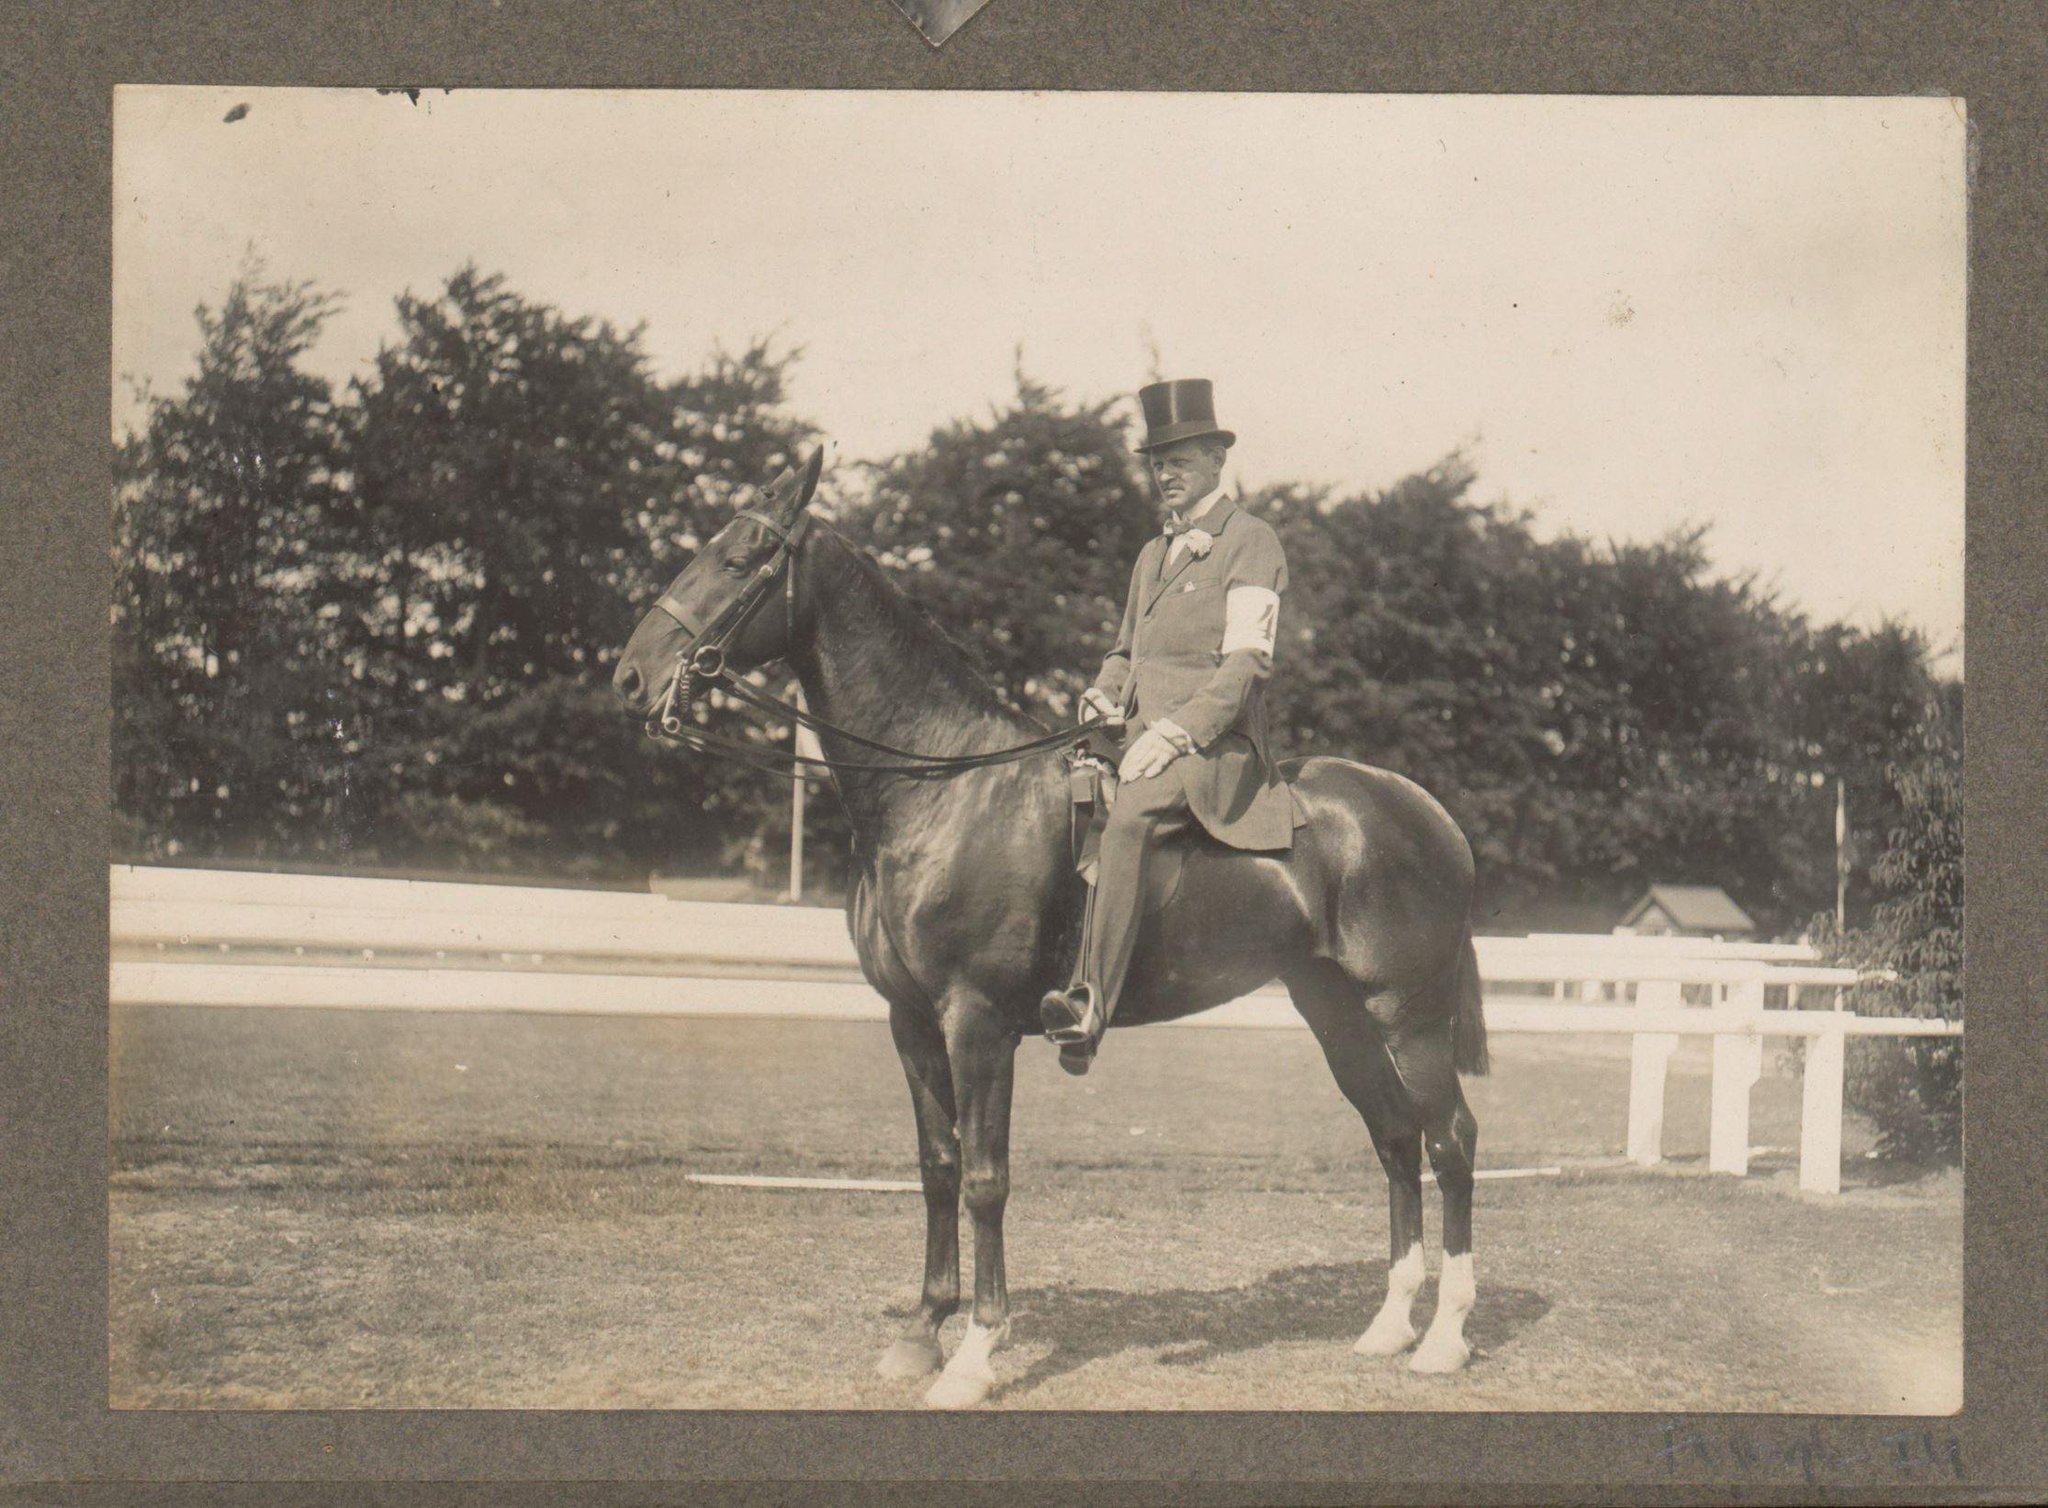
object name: album leaf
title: Ruitertafereel op Koninklijke Houtvesterij Het Loo: man te paard op een grasveld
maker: Anonymous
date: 1900-1925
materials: photographic support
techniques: gelatin silver print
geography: het loo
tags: riding a horse, ass, or mule; rider, horseman, hunting, chase, hunting-ground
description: Onderdeel van Fotoalbum van de heer Brams, opperhoutvester van koningin Wilhelmina op Koninklijke Houtvesterij Het Loo.